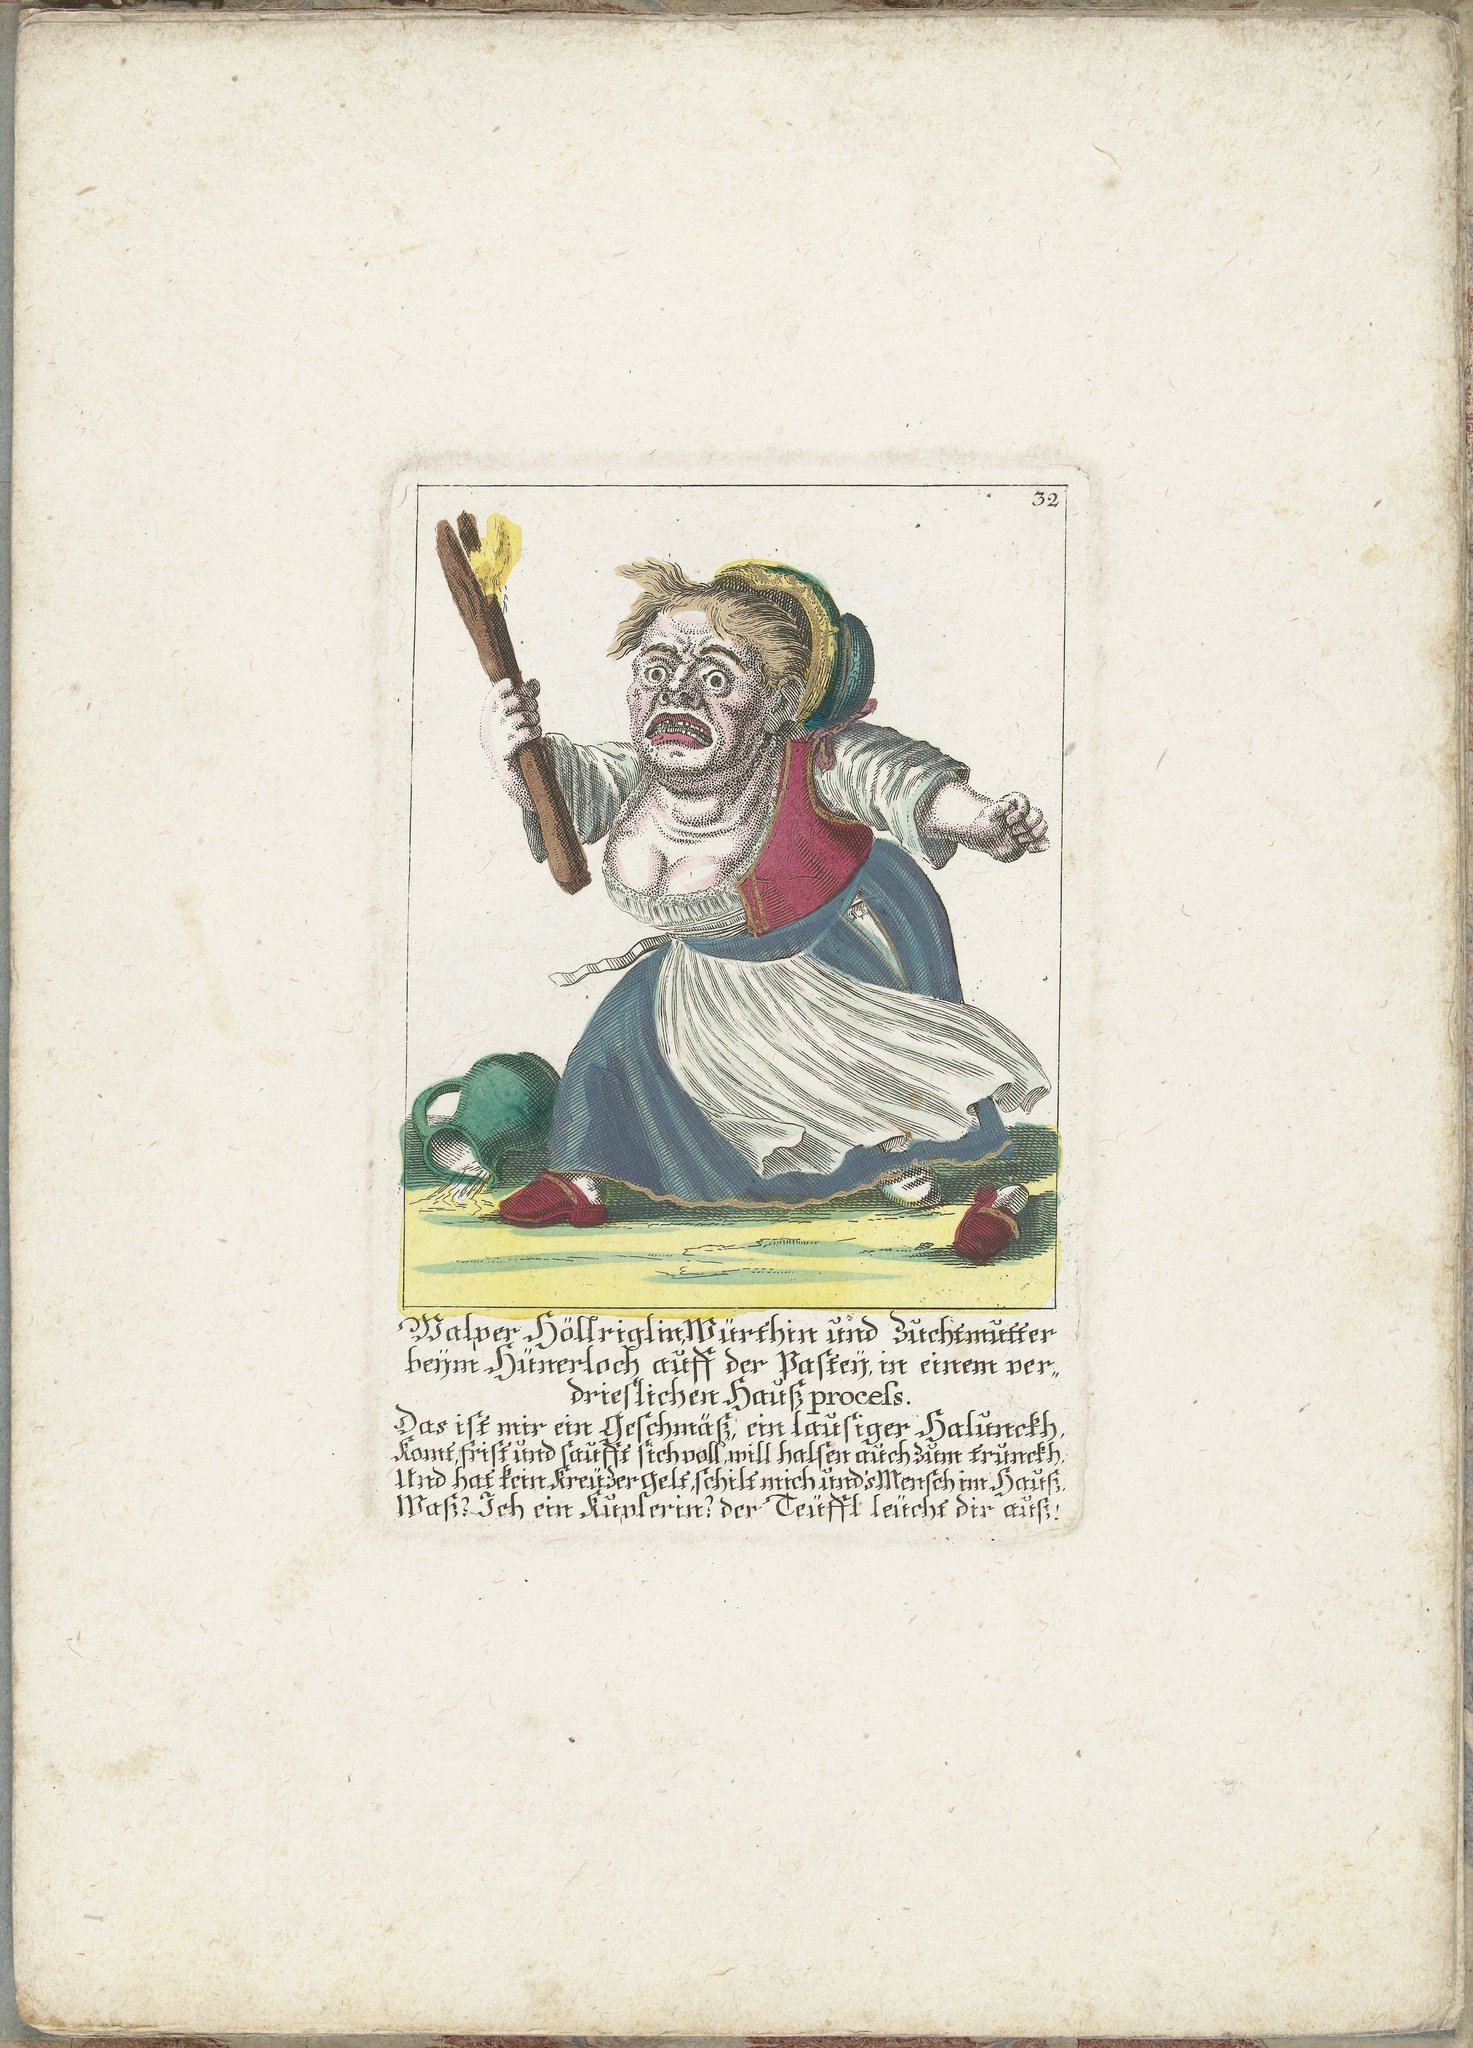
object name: print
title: De dwerg Malper Höllriglin als waardin, ca. 1710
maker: martin engelbrecht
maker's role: print maker, publisher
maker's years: 1684-1756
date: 1705-1715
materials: paper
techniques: engraving, etching, hand coloring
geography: augsburg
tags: caricatures (human types), little people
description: De kleine mens Malper Höllriglin als een boze waardin met een brandend stuk hout. In het onderschrift onder de titel een vierregelig vers in het Duits. Genummerd rechtsboven: 32. Onderdeel van een losbladige uitgave uit ca. 1710 van een serie karikaturen van kleine mensen, bekend als Het Dwergentooneel.